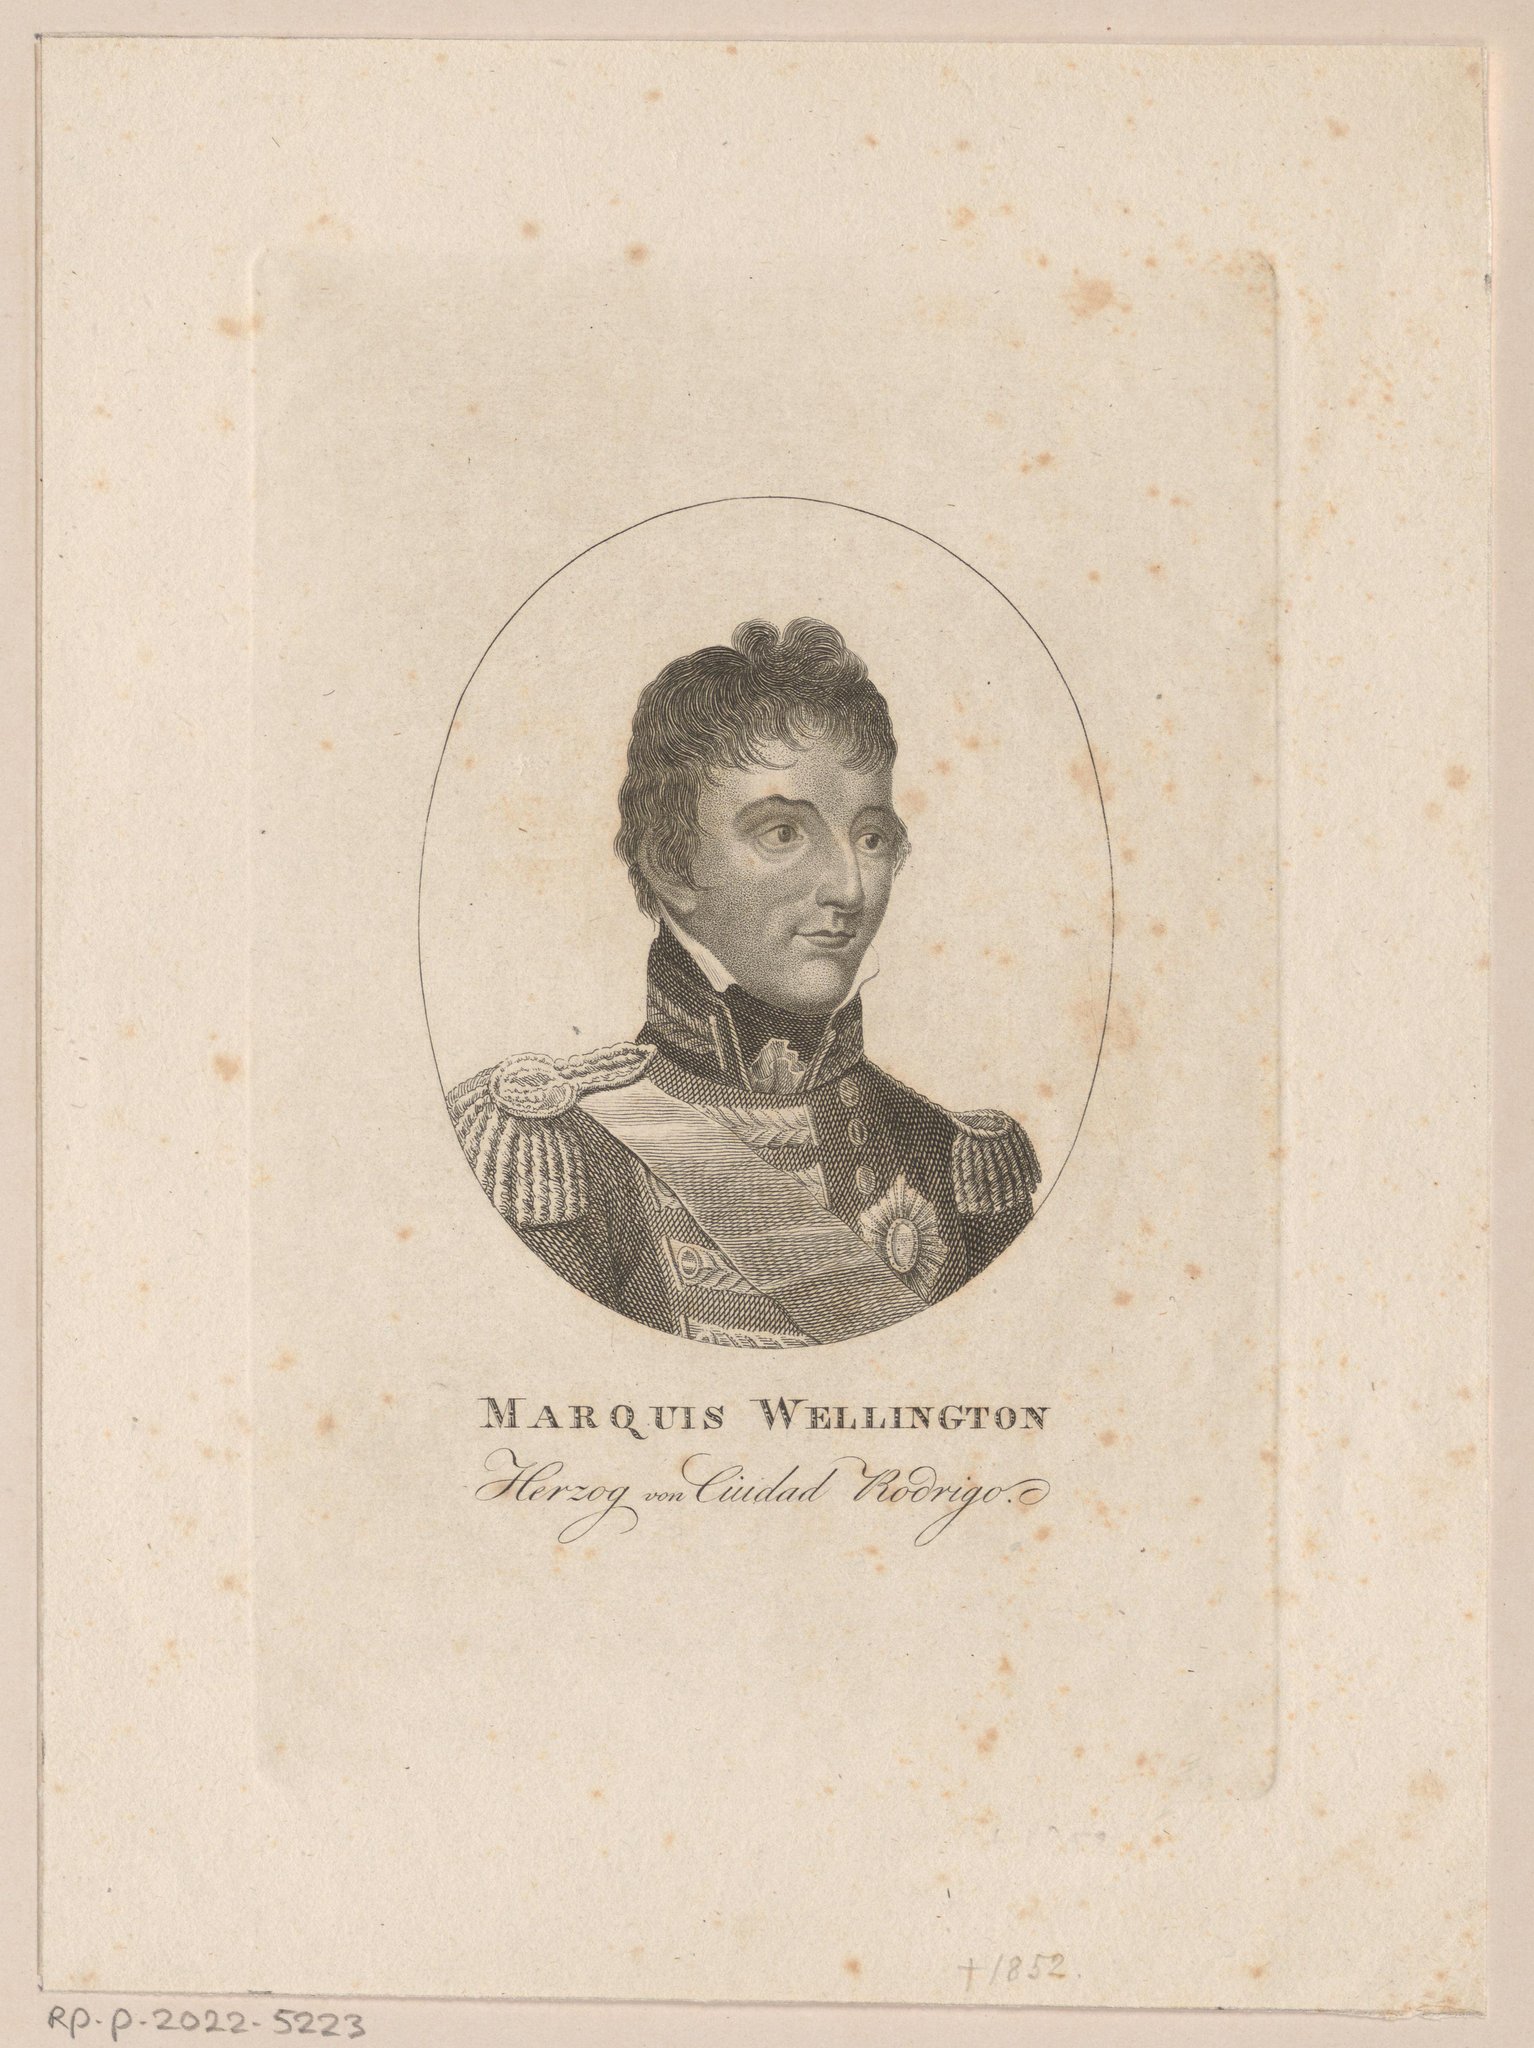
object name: print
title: Marquis Wellington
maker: Anonymous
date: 1800-1870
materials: paper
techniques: engraving, etching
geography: germany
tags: arthur wellesley of wellington, commander-in-chief, general, marshal, historical persons